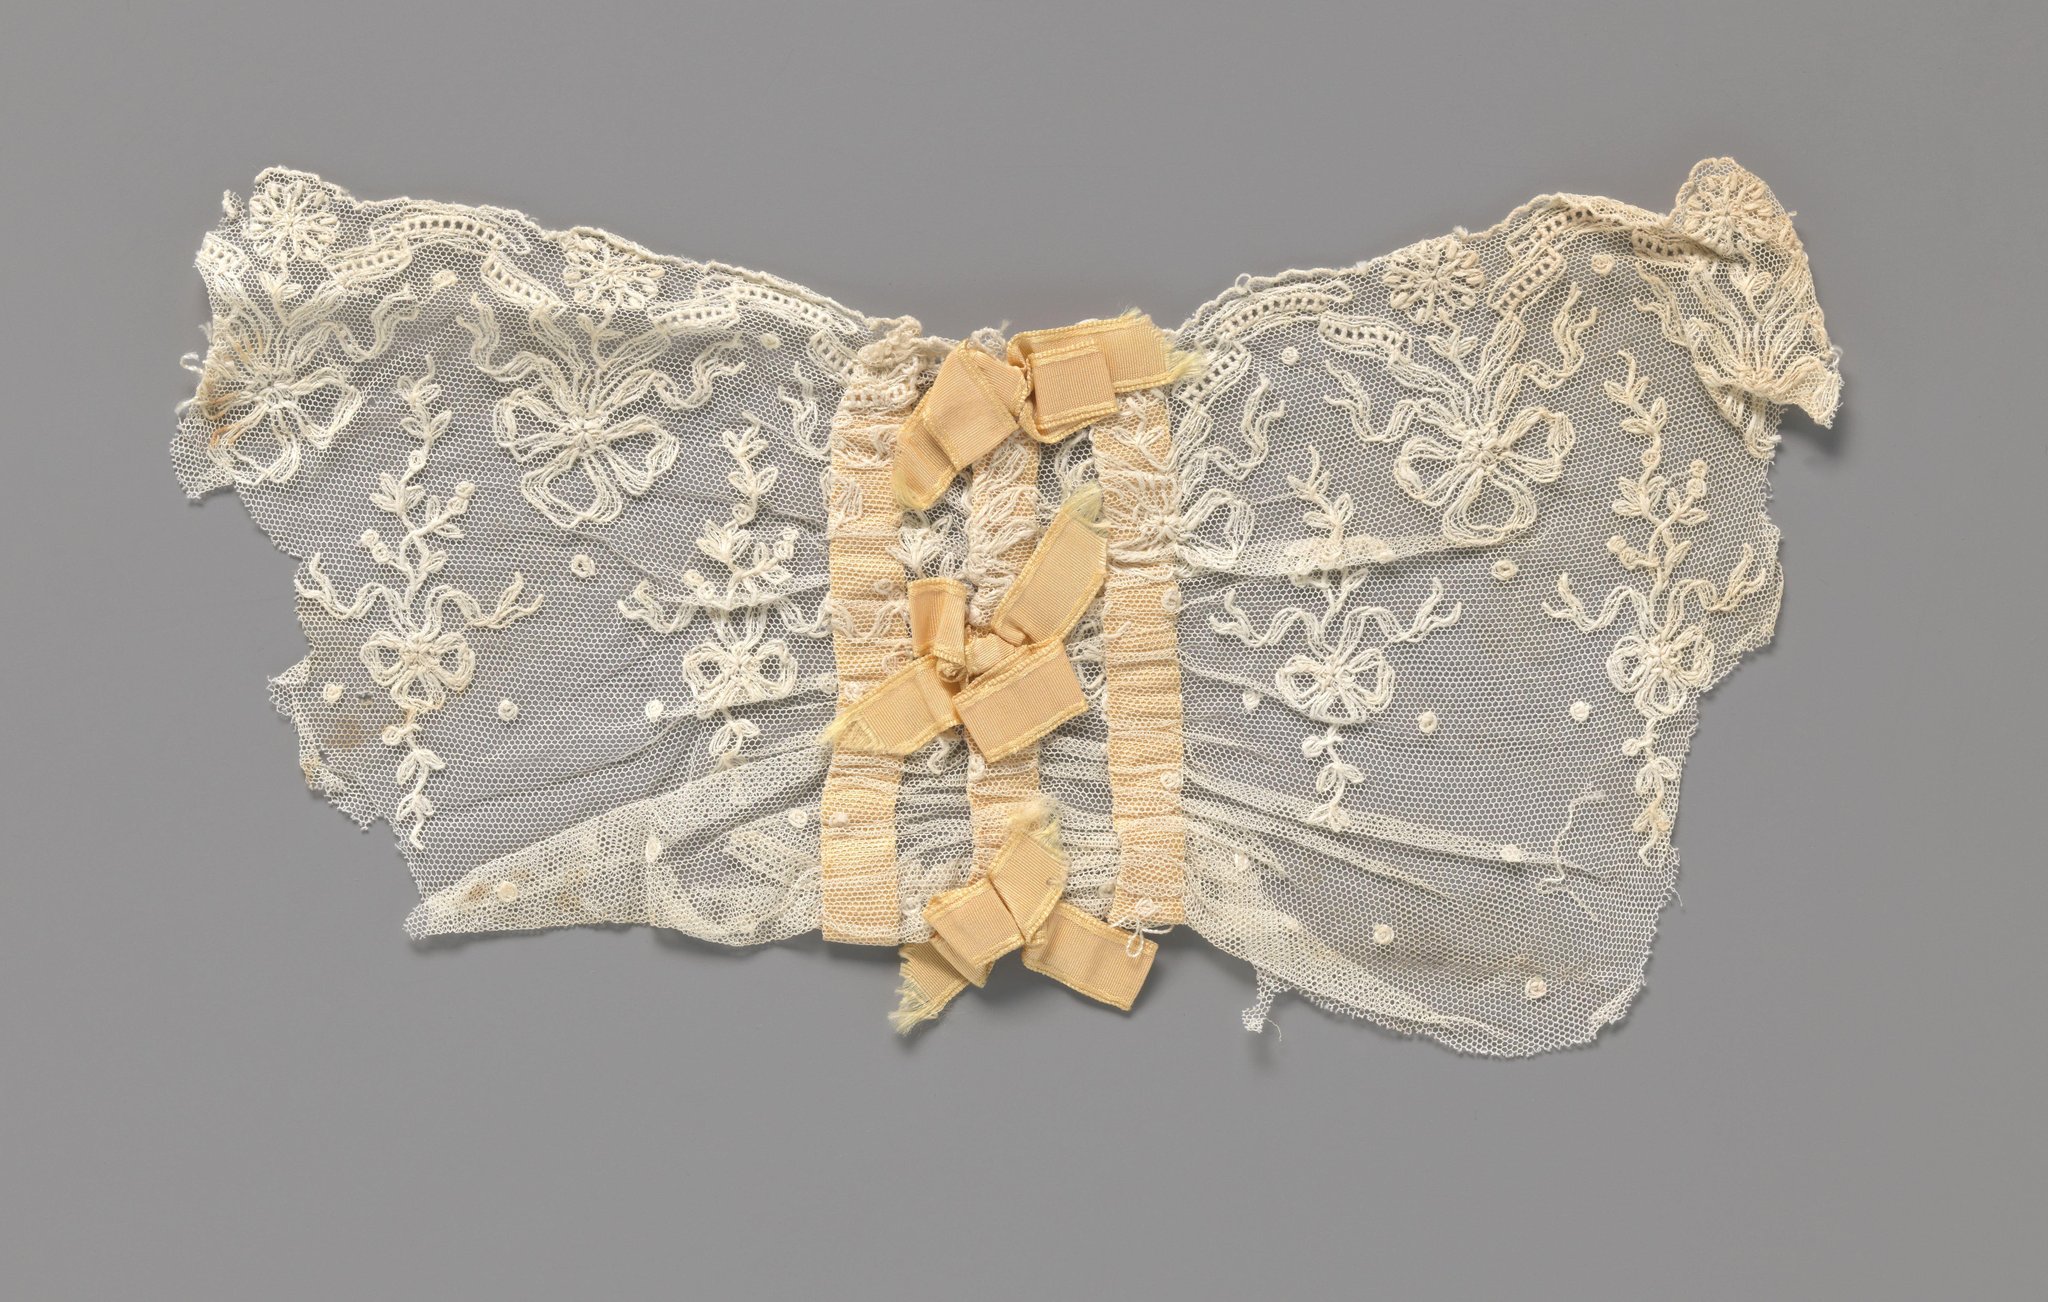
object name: cuff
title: Manchet van machinale kant met strikjes en met biezen en strikjes gemaakt met een lichtoranje lint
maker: Anonymous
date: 1900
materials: silk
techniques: lace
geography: europe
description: Manchet van naturelkleurige machinale kant: machinaal borduurwerk op machinale tule. Vlindervormig model, met in het midden biezen en strikjes van lichtoranjekleurige zijden lint. Het kantpatroon bestaat uit een strooipatroon van moesjes en twee rijen geborduurde strikjes waarbij de strikken in de bovenste rij groter zijn. Deze strikken hangen vanaf de schulpenrand tussen twee geborduurde linten naar beneden, onder een rozetbloem en in de rij daaronder zijn kleinere strikjes geborduurd, verbonden aan een langerekte bloemtak.